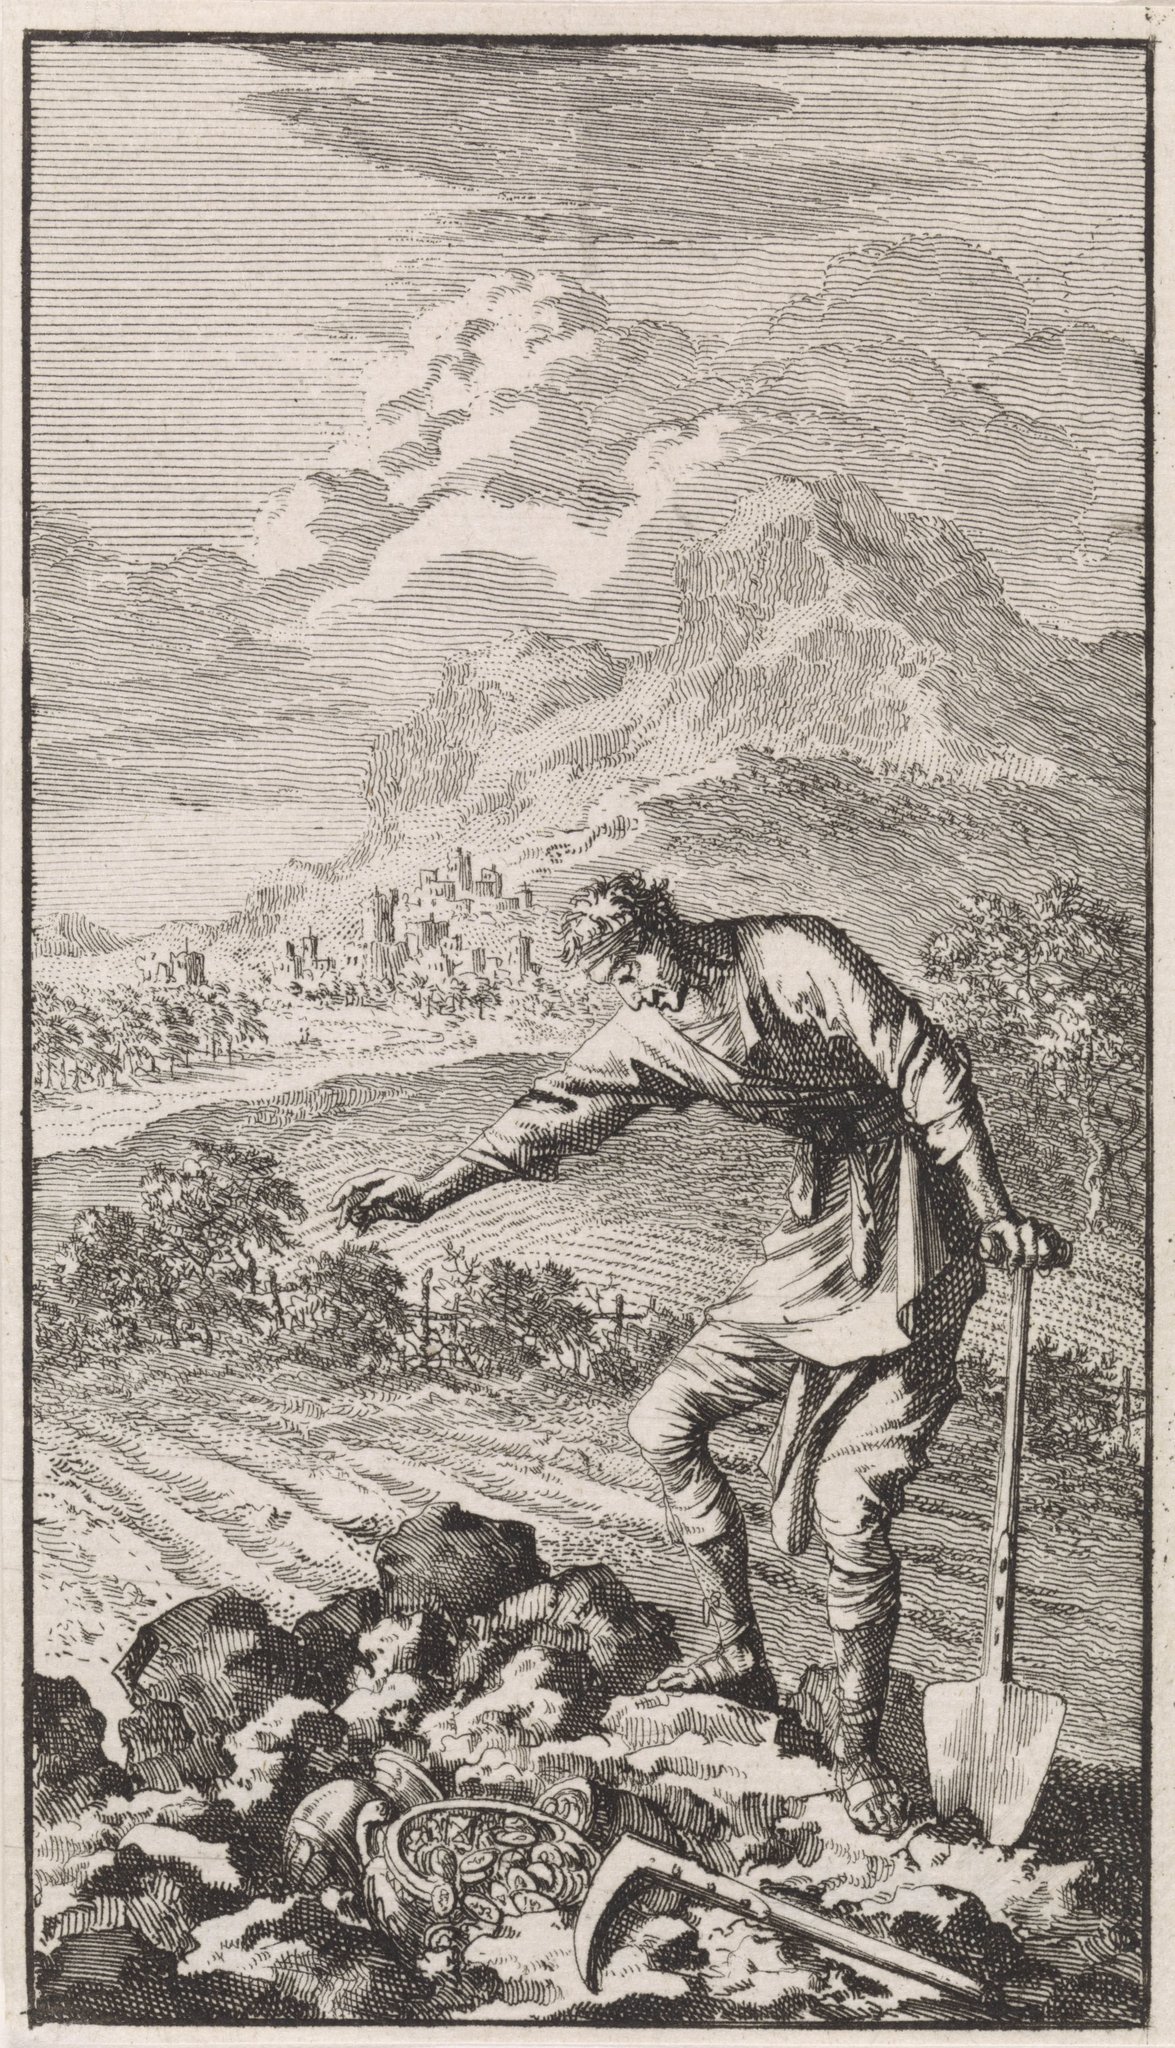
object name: print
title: Gelijkenis van de schat in de akker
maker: jan luyken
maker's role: draughtsman, print maker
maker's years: 1649-1712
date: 1712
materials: paper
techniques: etching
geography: amsterdam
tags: 'the kingdom of heaven is like treasure hidden in a field' ~ proverbial saying of christ (matthew 13:44)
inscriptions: collector's mark: Lugt 2228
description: Proefdruk van illustratie voor: Luyken, Jan. Bybel printen. Amsterdam: Pieter Arentsz. II (wed.) en Cornelis van der Sys, 1712, p. 19.